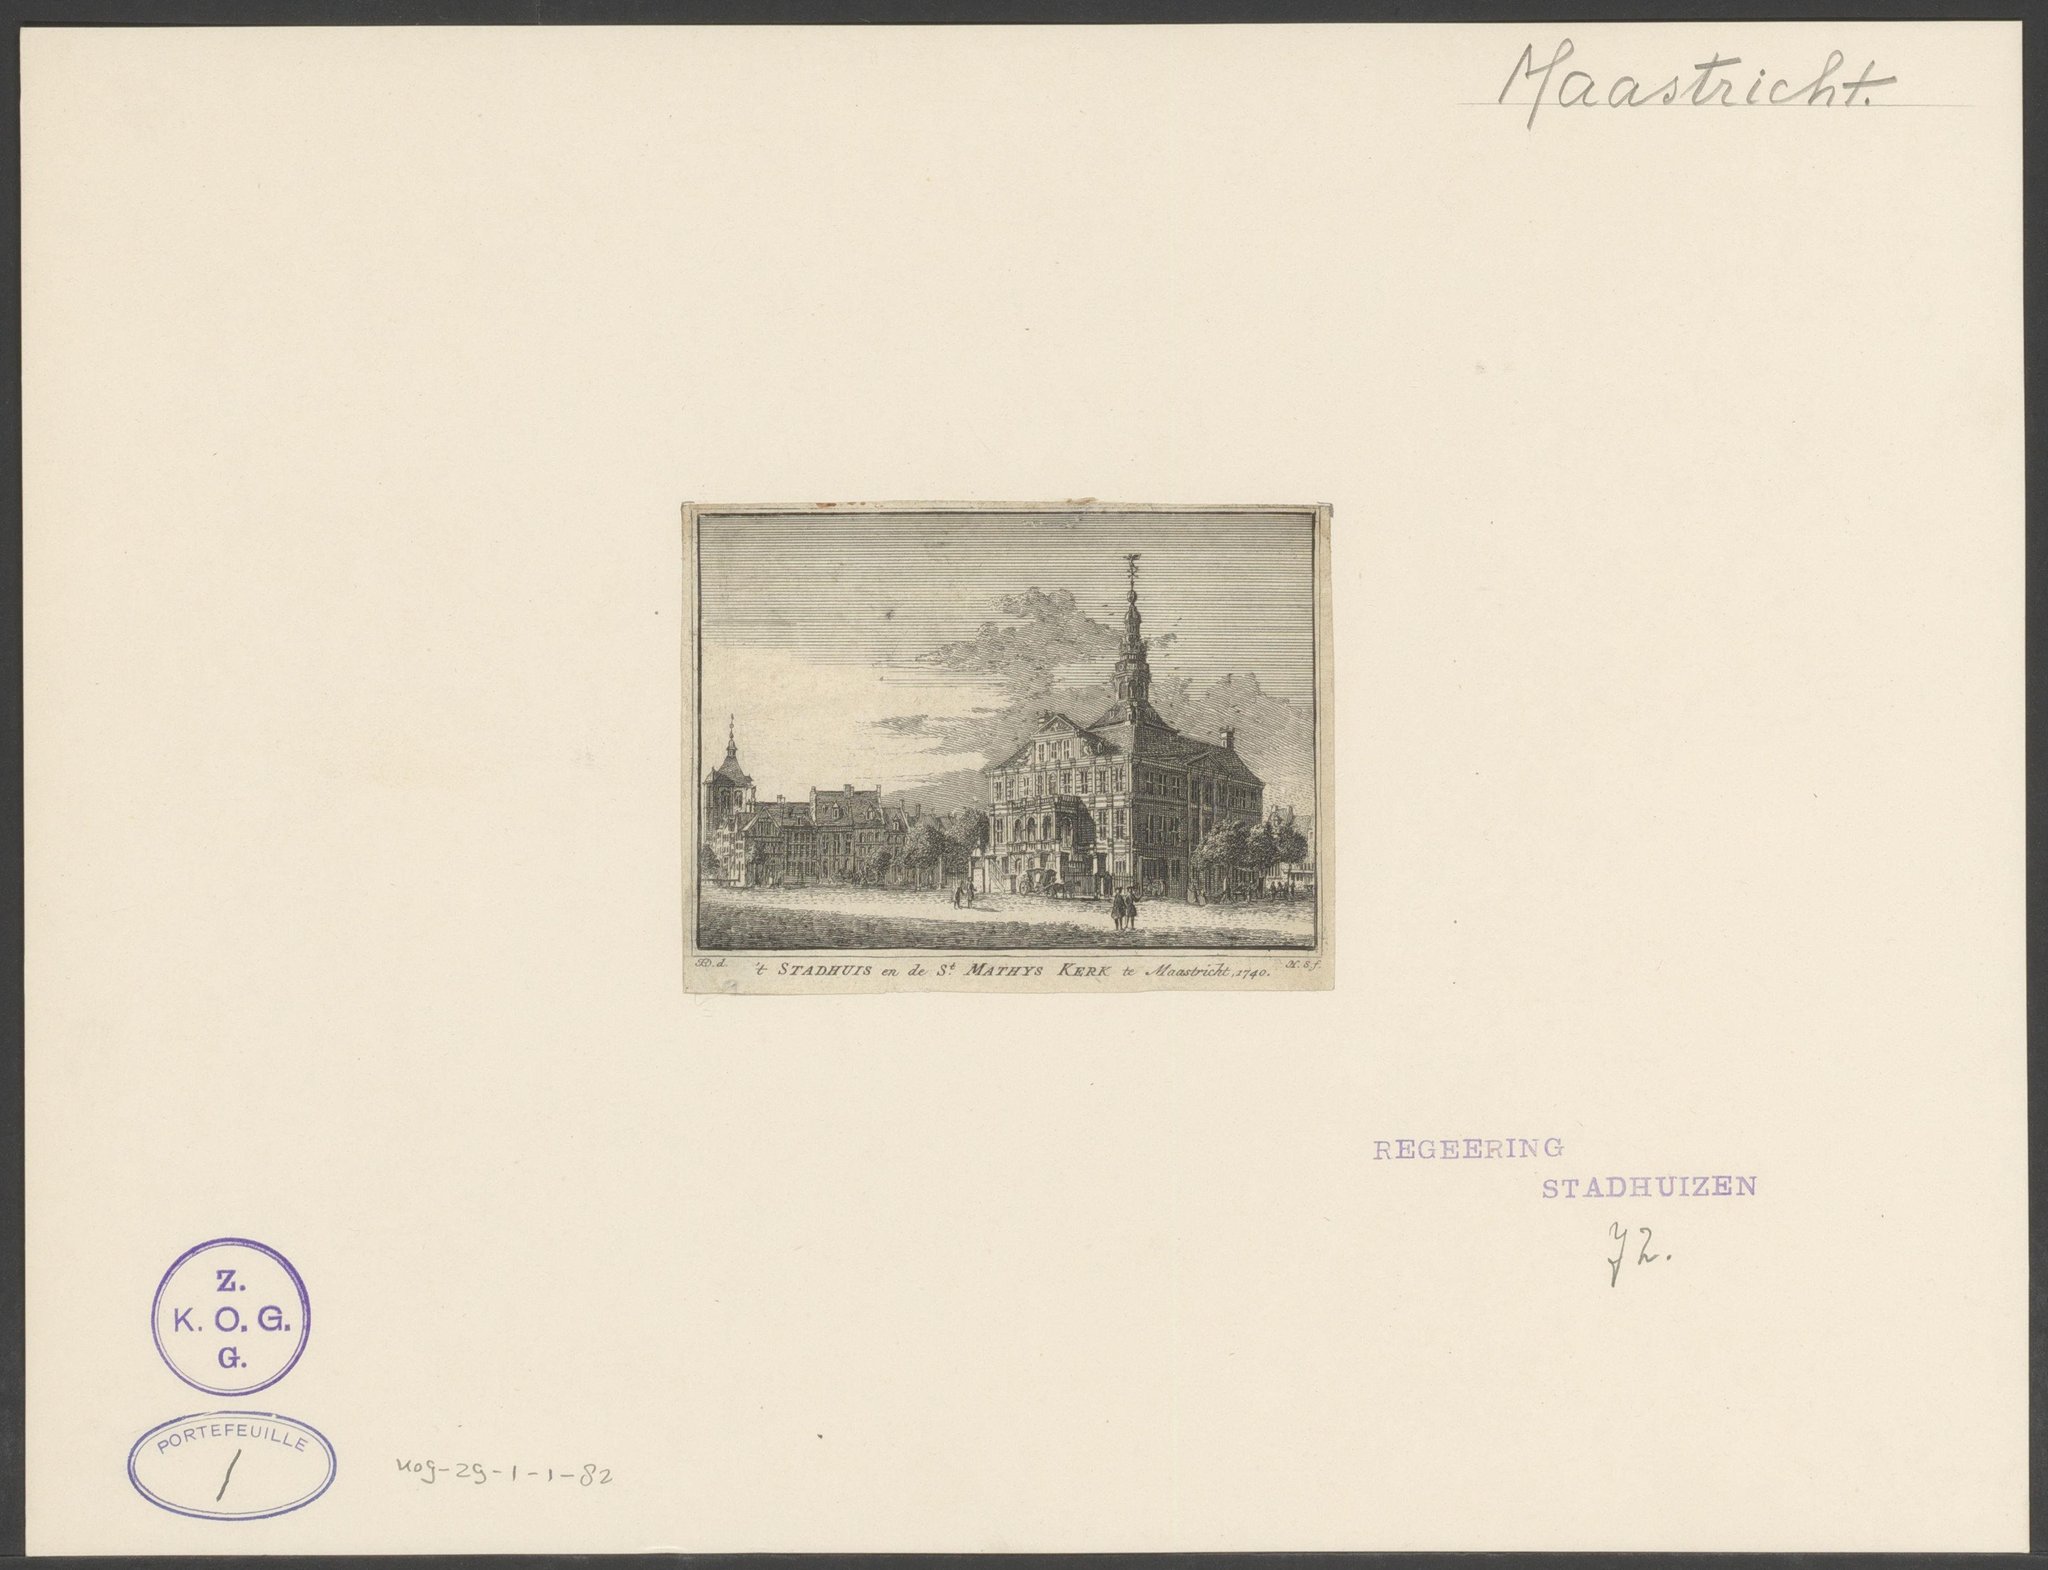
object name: print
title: 't Stadhuis en de St. Mathys Kerk te Maastricht, 1740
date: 1746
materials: paper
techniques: engraving, etching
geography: northern netherlands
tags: church (exterior), townhall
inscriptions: collector's mark: Lugt 1641, collector's mark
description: Prent eerst gebruikt in: Het verheerlykt Nederland of kabinet van hedendaagsche gezigten van steden, dorpen (…). 9 delen. Amsterdam: Isaak Tirion en weduwe Isaak Tirion, 1745-1774, dl. 2 (1746), ill. 127-128. Later ook gebruikt in: Nederlandsche tafereelen; of eene keurige verzameling van negen honderd fraaije gezigten van steden, dorpen, sloten, oudheden (...). 9 delen. Amsterdam: Jan de Groot, 1792, dl. 2, ill. 127-128.